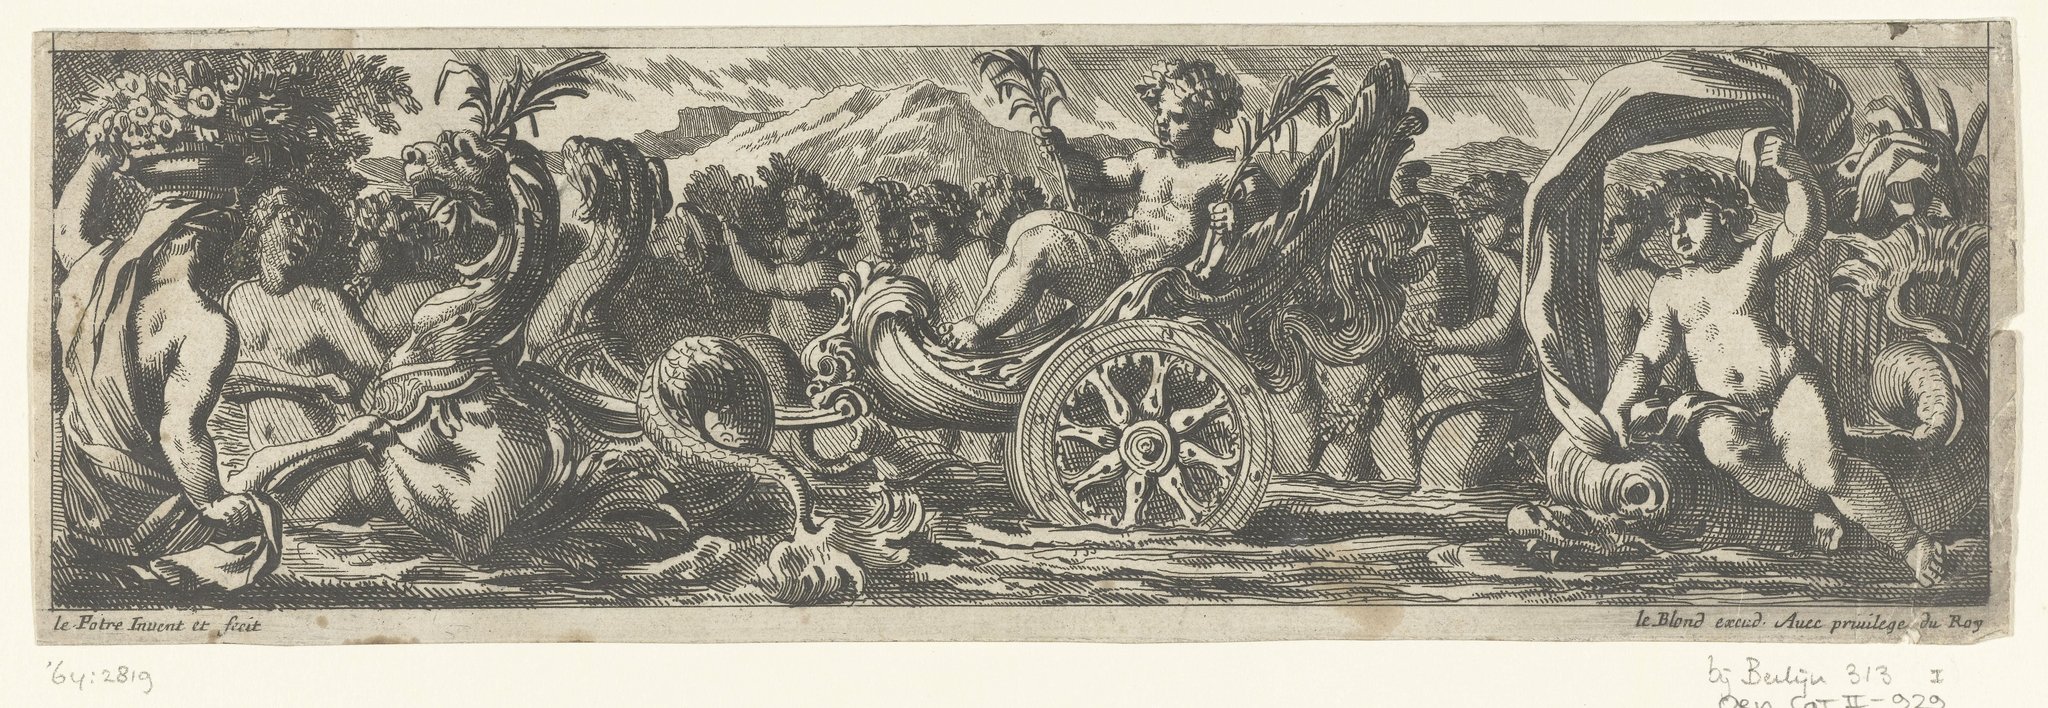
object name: ornament print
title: Friezen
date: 1650-1666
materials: paper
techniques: etching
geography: paris